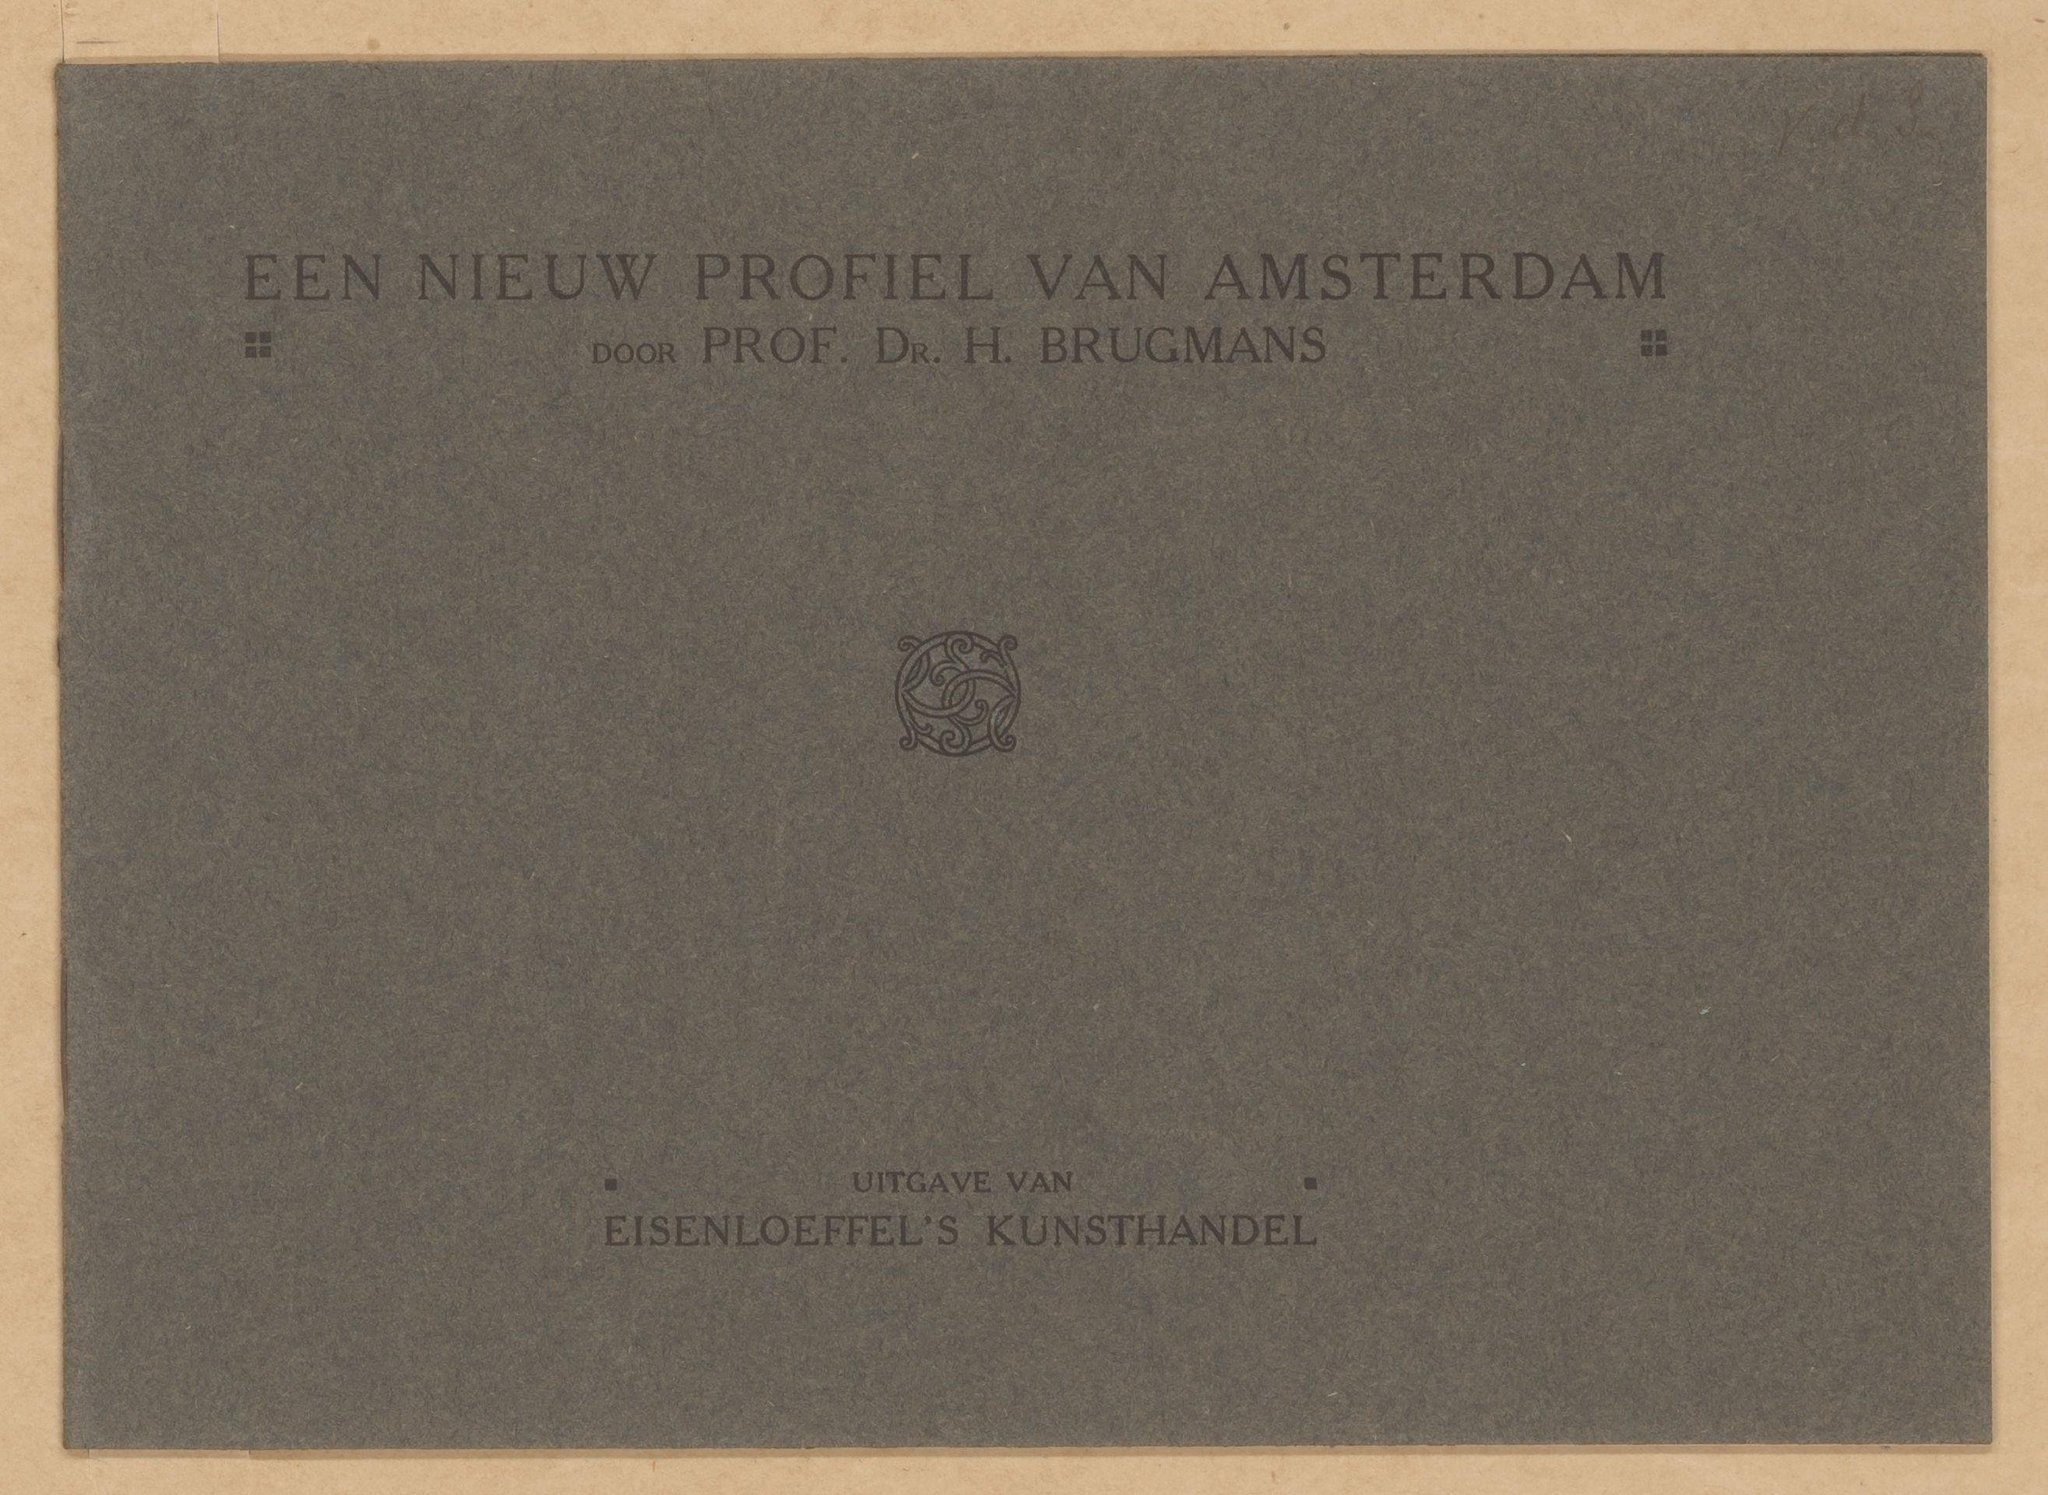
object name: text sheet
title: Beschrijving van het profiel van de stad Amsterdam door de eeuwen heen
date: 1891-1974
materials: paper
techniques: letterpress printing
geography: amsterdam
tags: city-view in general; 'veduta', amsterdam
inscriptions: collector's mark: ‘1-’ Lugt 1641b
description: Onderwerpsrubriek binnen de Atlas Amsterdam: Gezichten van den geheelen IJkant der Stad. Tekstboek bestaande uit 11 bladzijden.